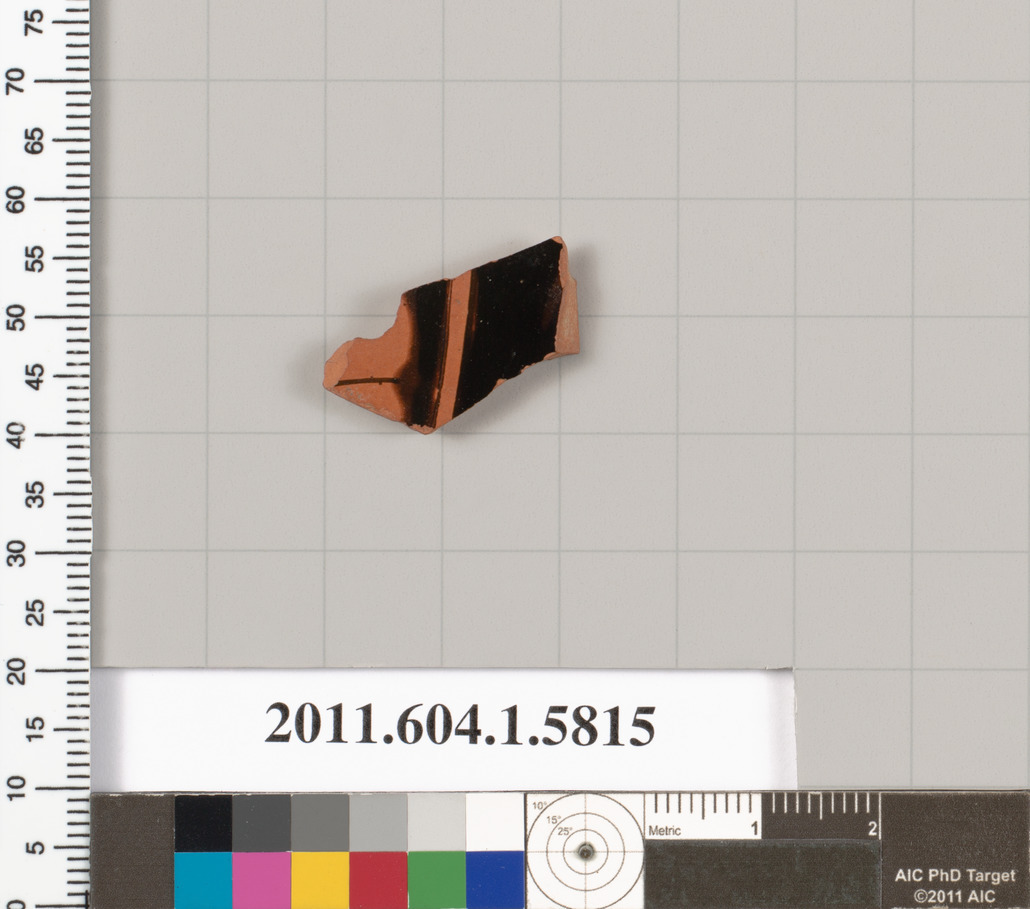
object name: kylix fragment, eye cup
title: Terracotta fragment of a kylix: eye-cup (drinking cup)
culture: greek, attic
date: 520-510 BCE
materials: terracotta